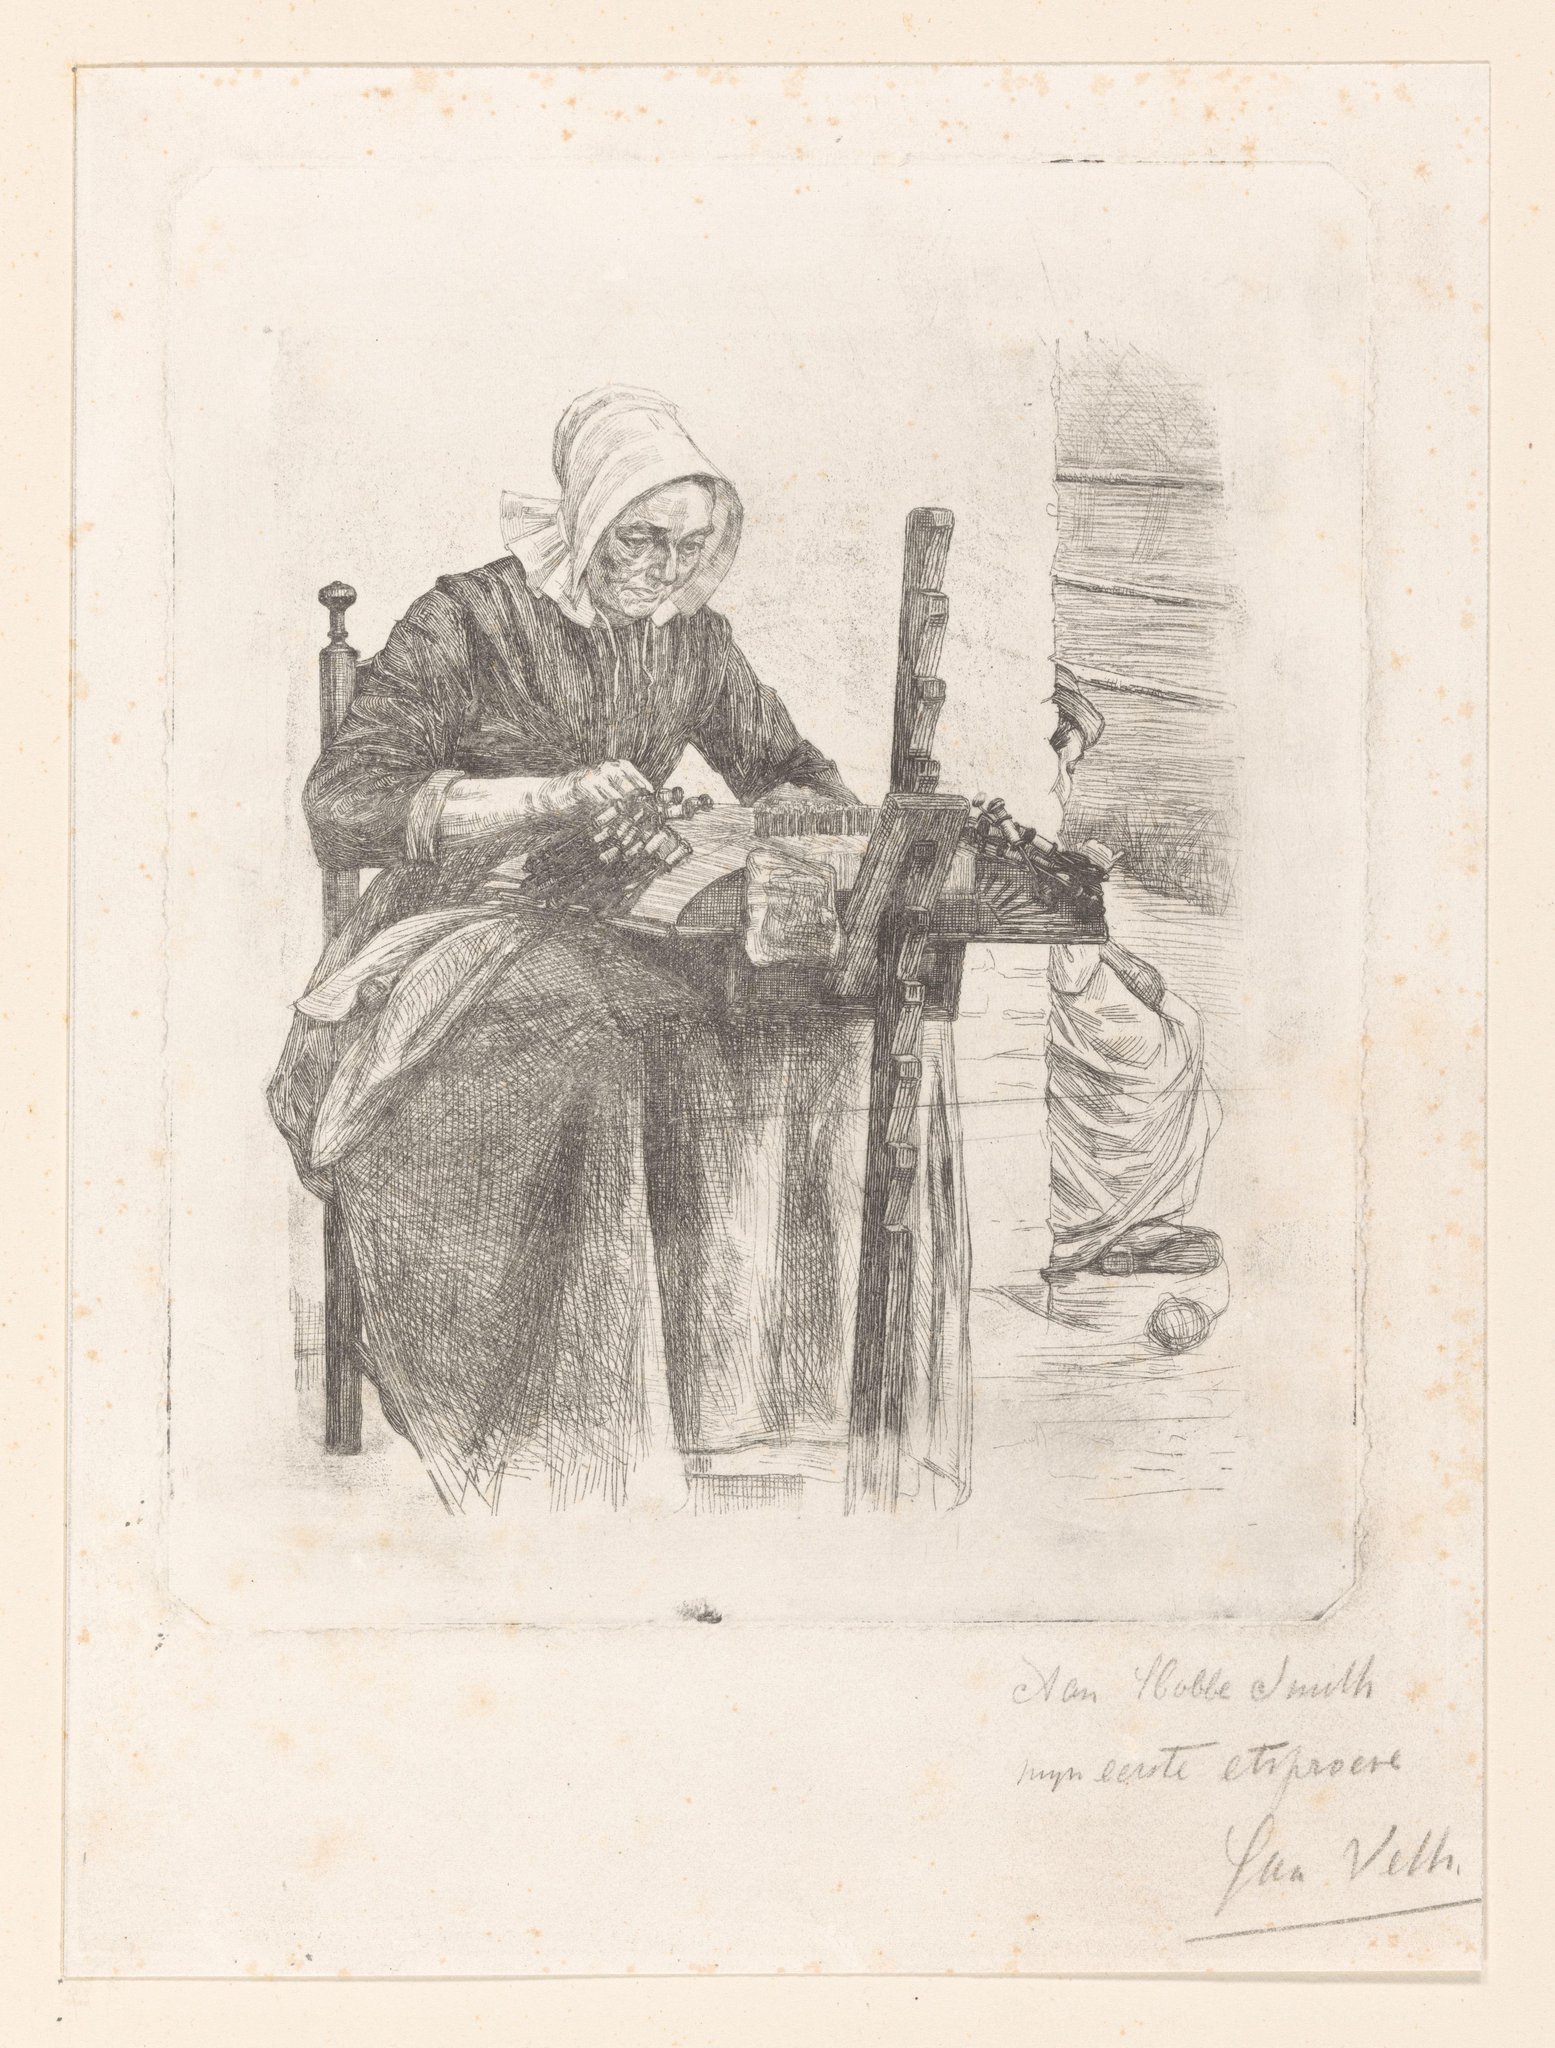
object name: print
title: Kantwerkster te 's Gravemoer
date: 1885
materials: paper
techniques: etching, intaglio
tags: lace, sewing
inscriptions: dedication: ‘Aan Hobbe Smith/ mijn eerste etsproeve/ Jan Veth’, collector's mark: Lugt 2228